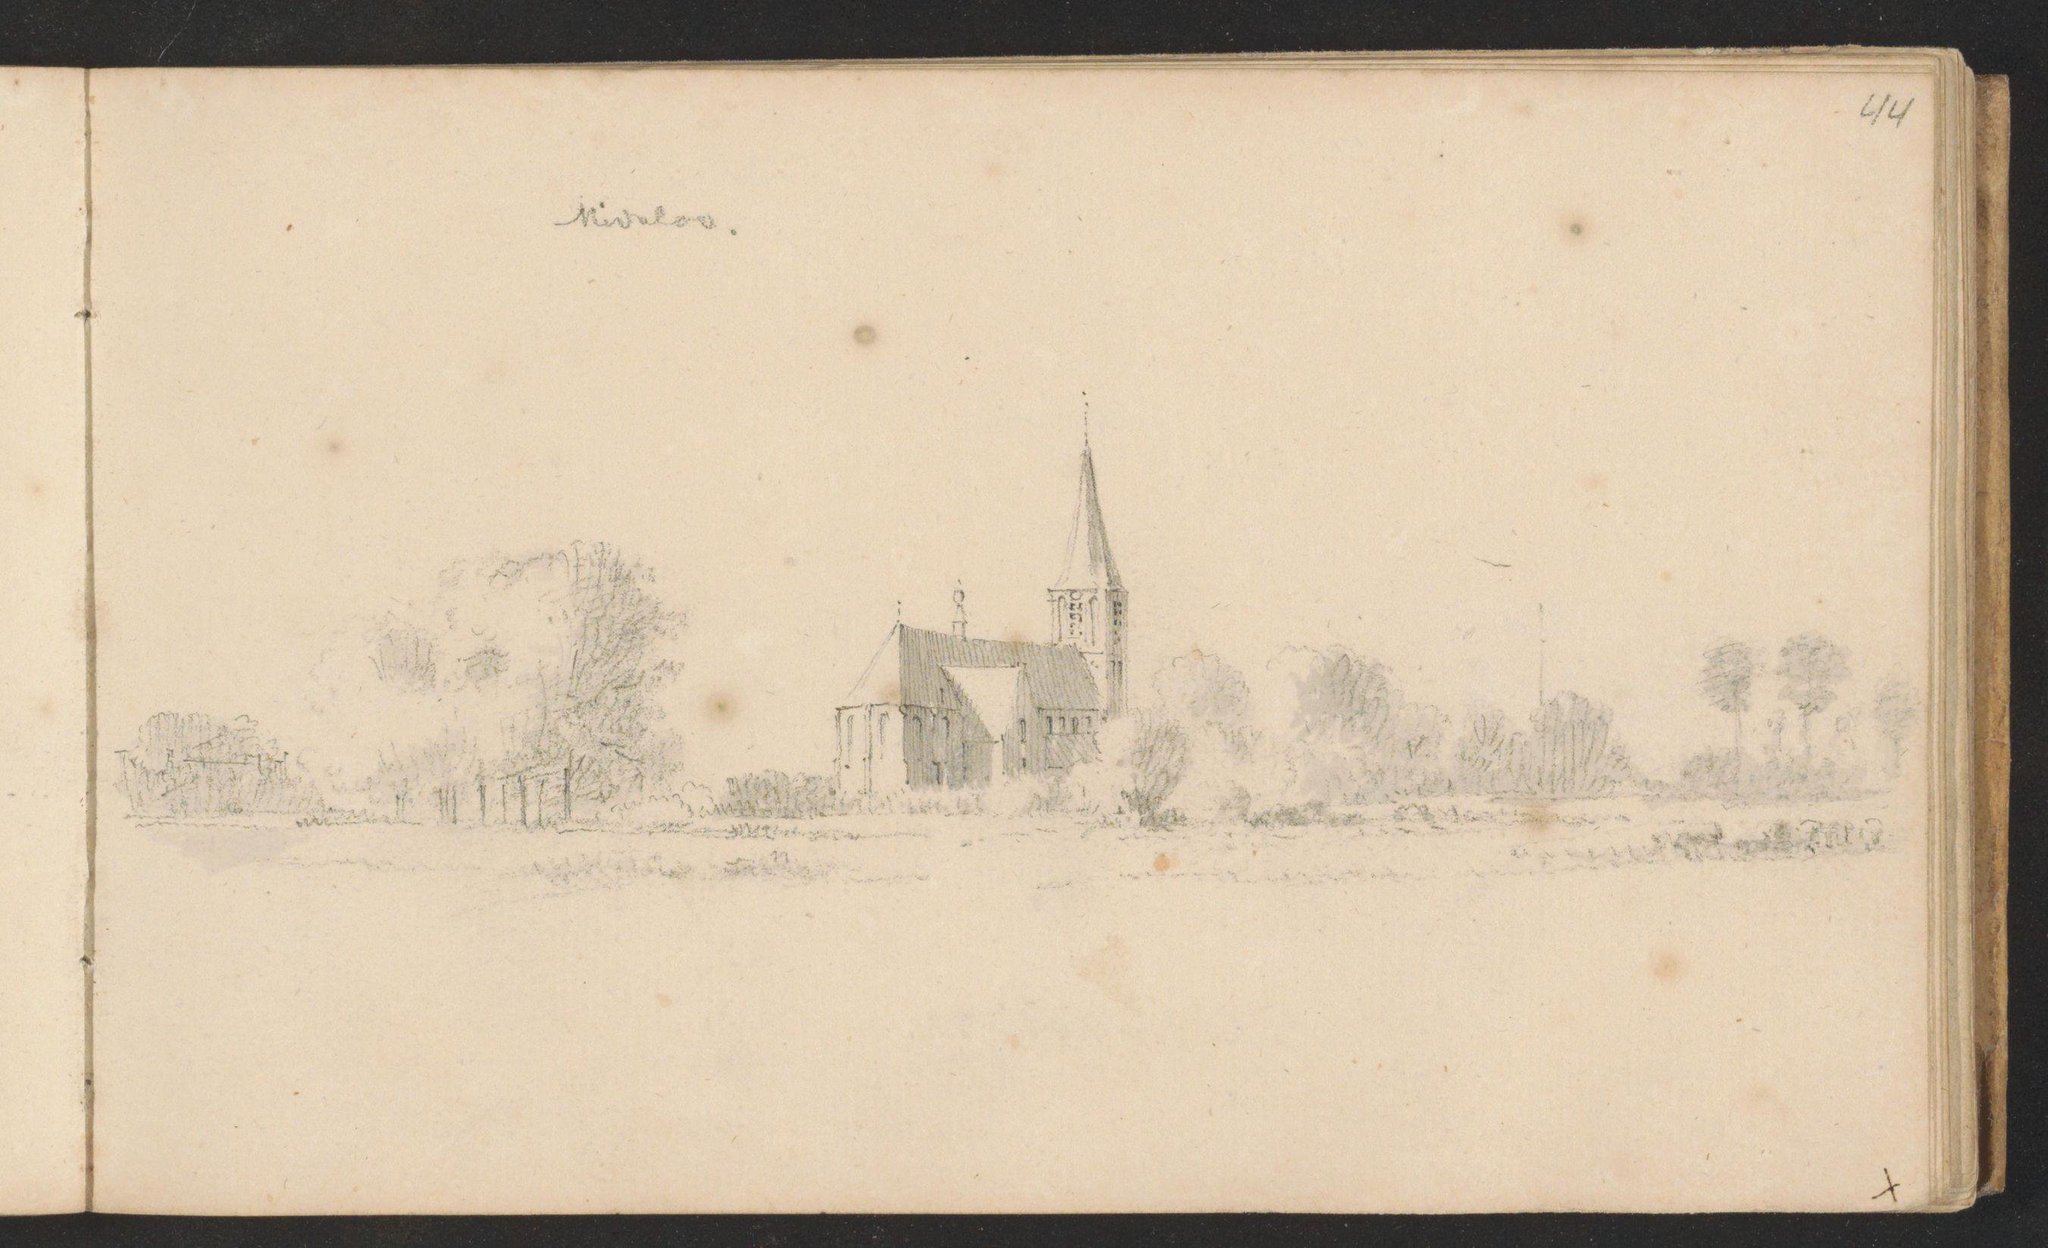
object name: sketchbook leaf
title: Kerk van Mierlo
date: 1701-1759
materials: paper, pencil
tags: church (exterior)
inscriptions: annotation: ‘Mierloo’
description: Blad 44 recto uit een schetsboek met 65 bladen.